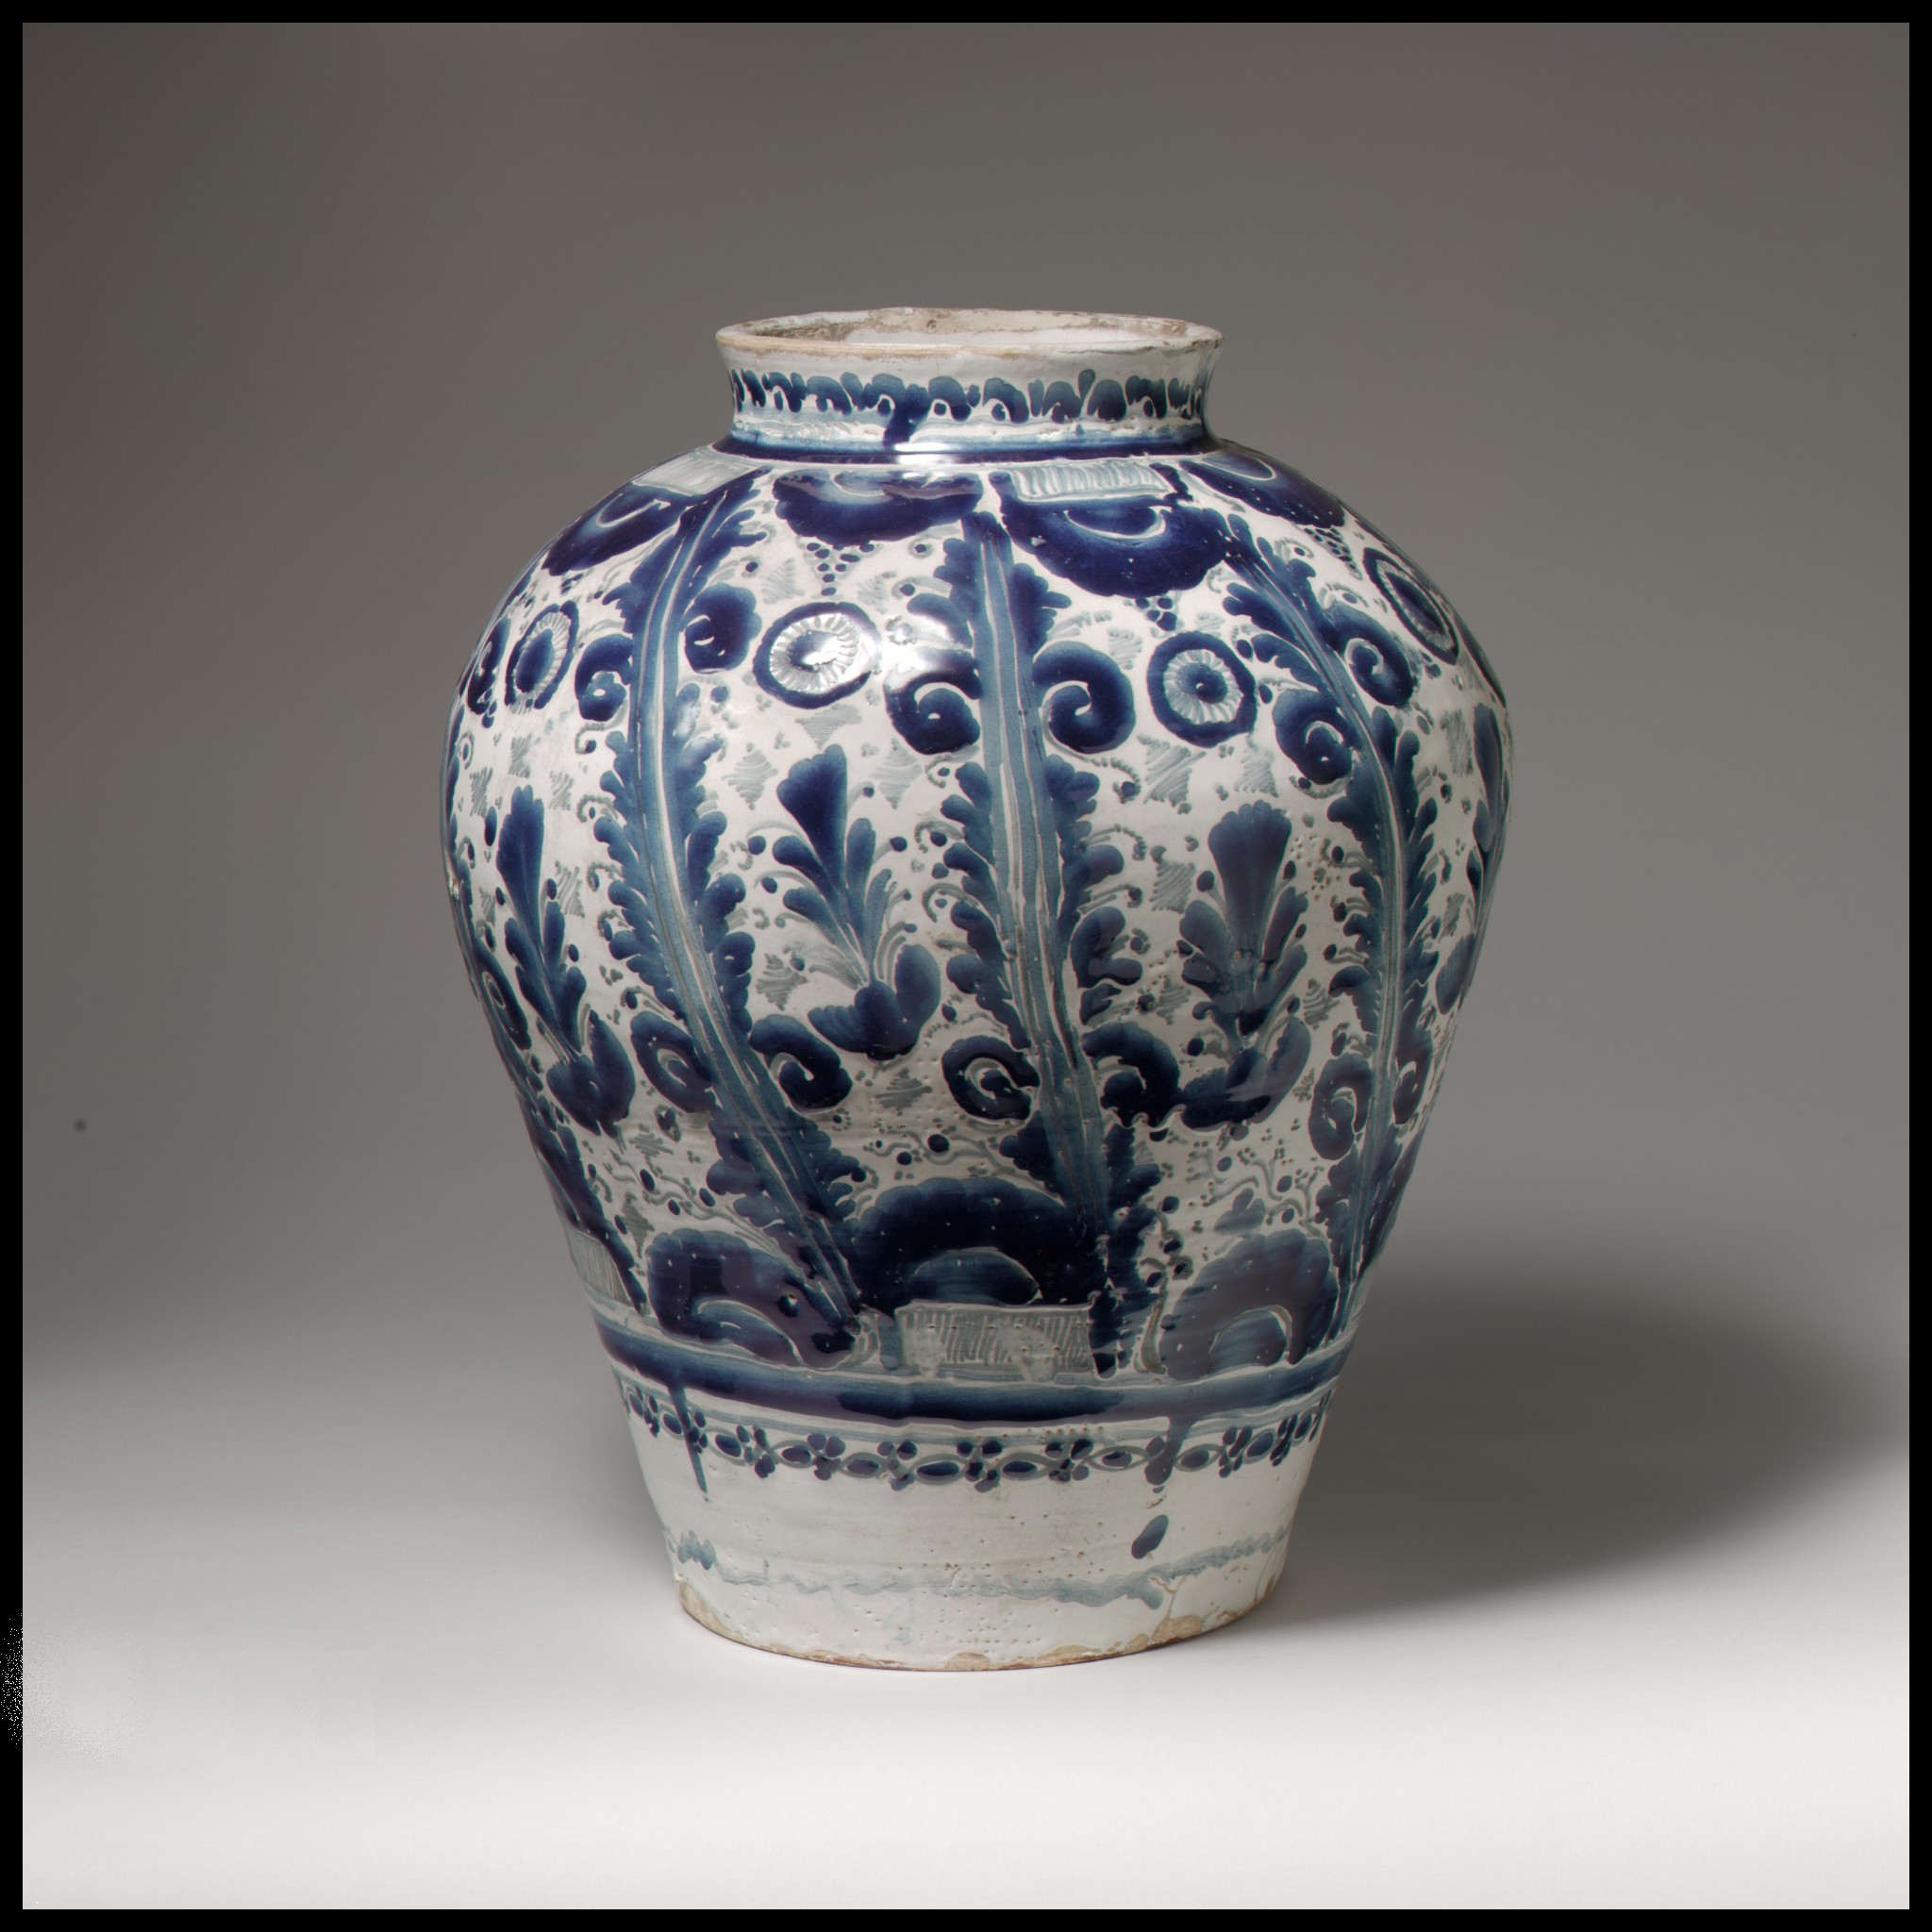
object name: jar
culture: mexican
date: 1700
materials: earthenware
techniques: glazing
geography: mexico